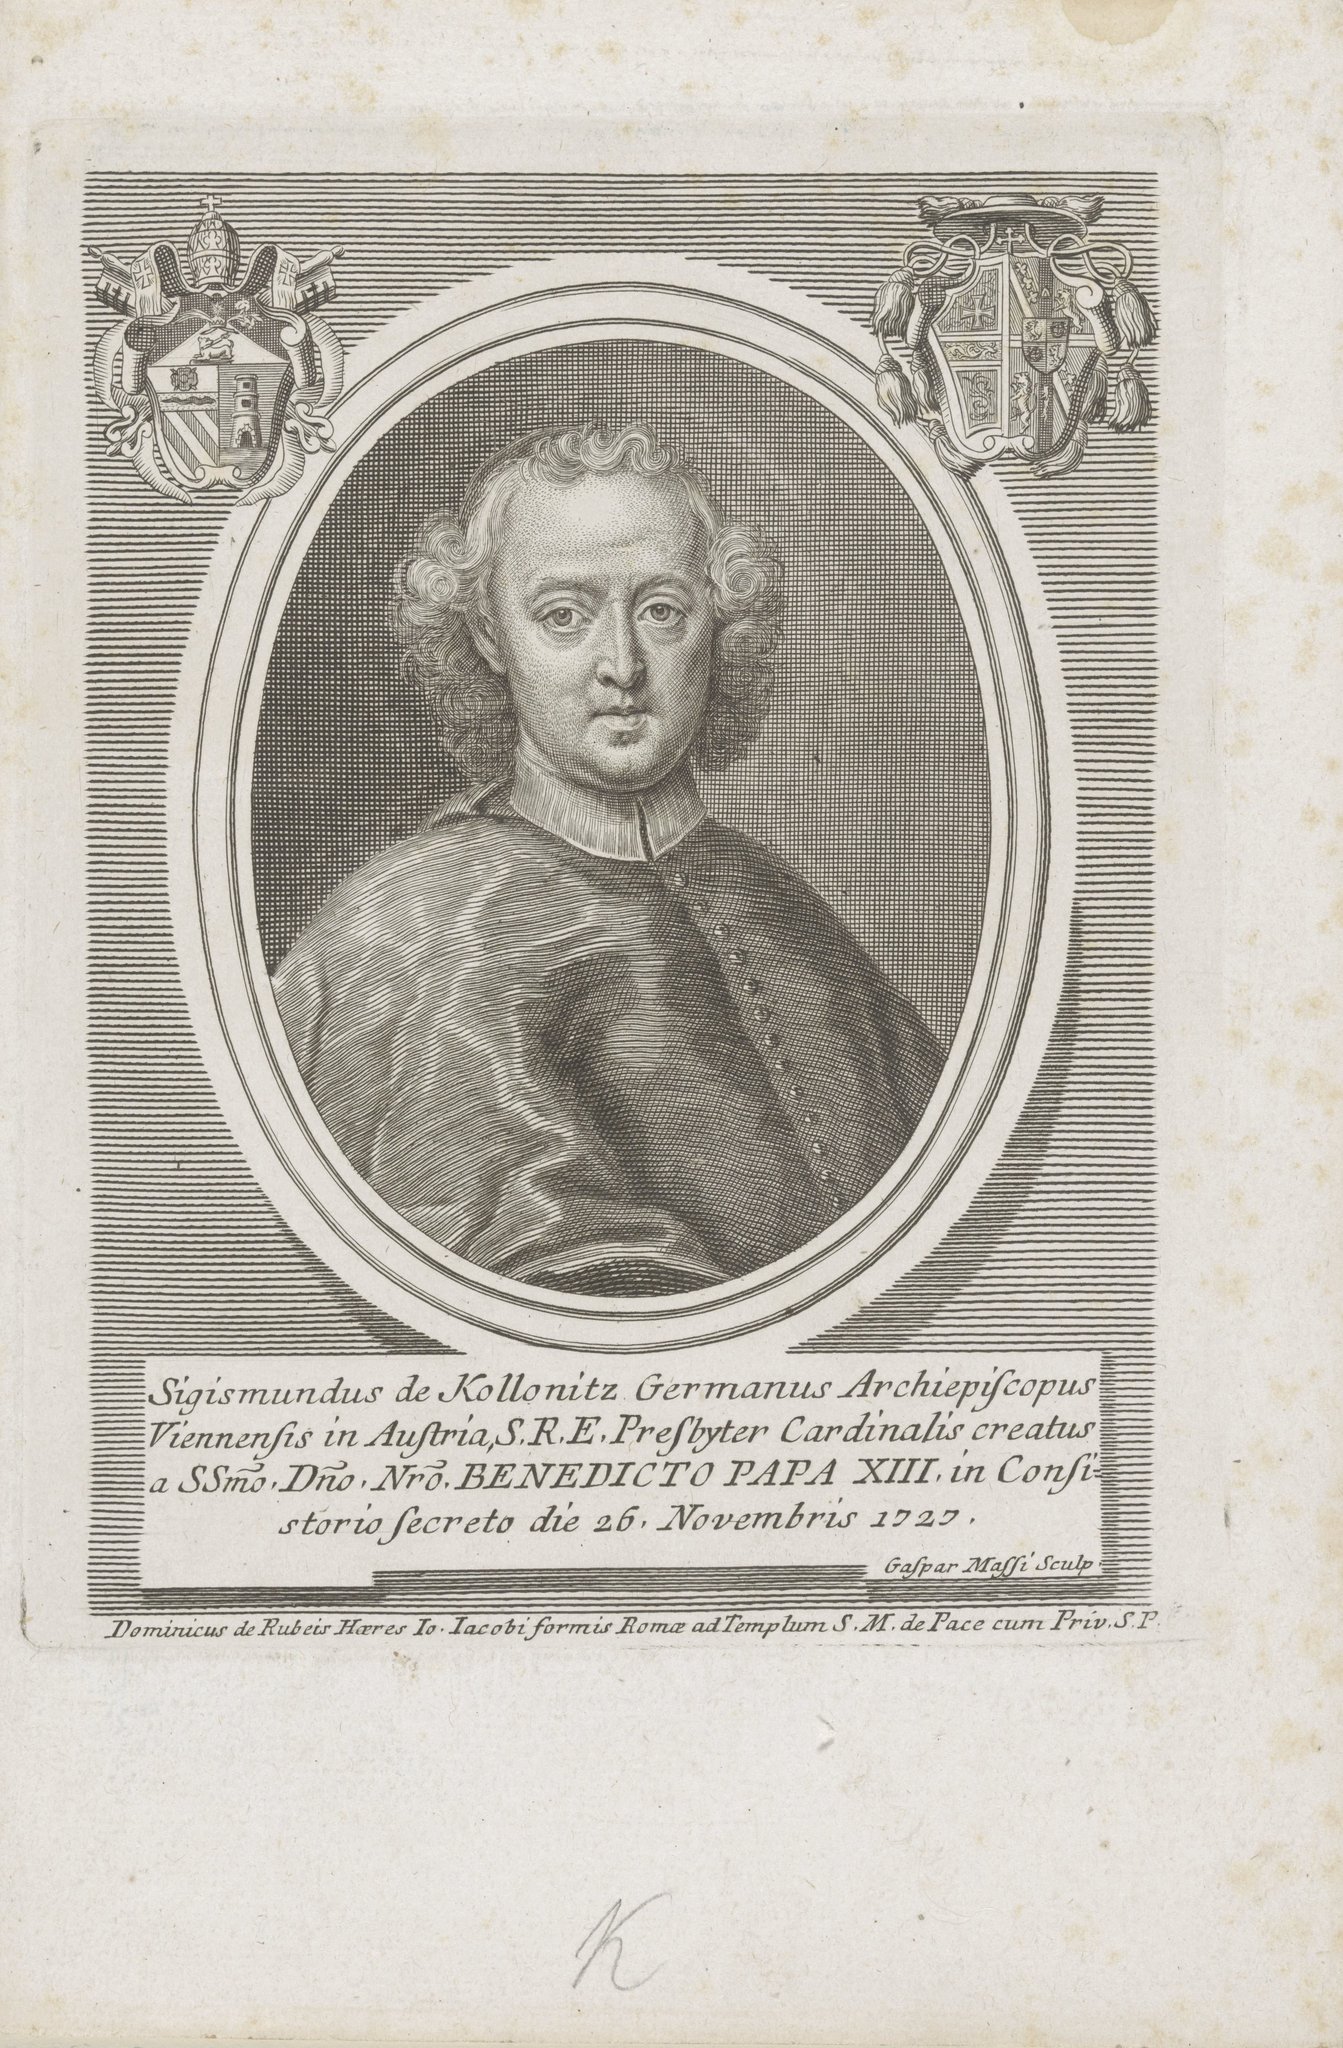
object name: print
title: Effigies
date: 1727-1731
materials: paper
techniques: engraving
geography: vatican city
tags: vienna, cardinal, historical persons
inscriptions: collector's mark: Lugt 2228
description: Prent uit een reeks van onbekende omvang met portretten van kardinalen. De prenten werden vanaf 1657 vervaardigd in opdracht van uitgever Giovanni Giacomo de’ Rossi, waarna de productie werd voortgezet onder leiding van zijn opvolgers Domenico de’ Rossi en Lorenzo Filippo de’ Rossi, en tenslotte onder leiding van de Calcographia R.C.A.